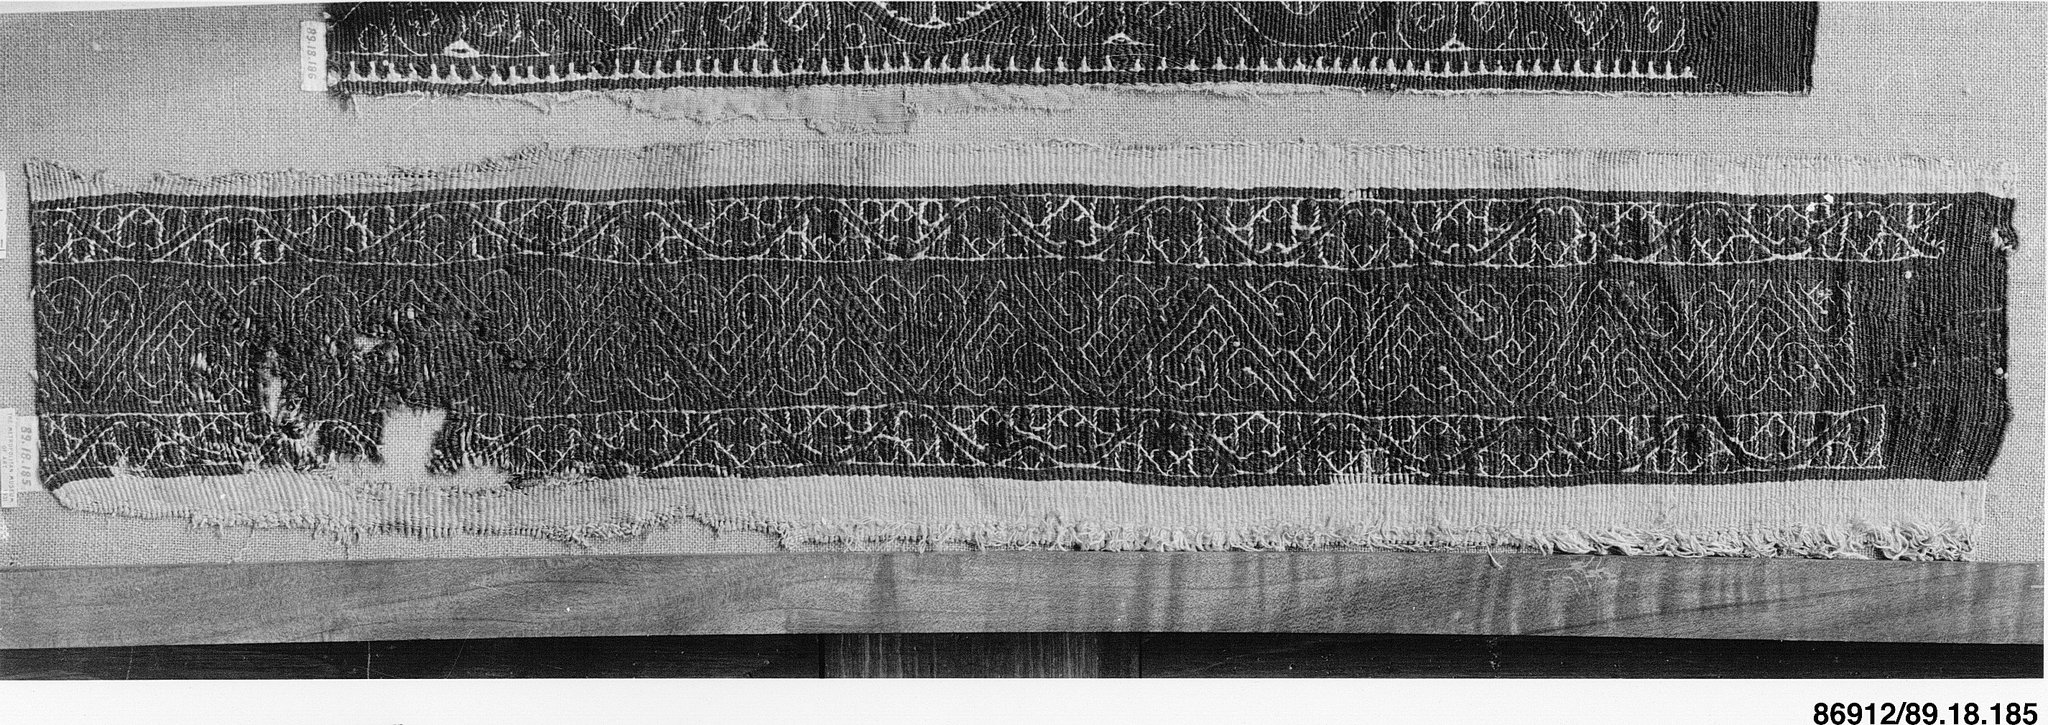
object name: textile fragment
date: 201-400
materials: linen, wool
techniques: weave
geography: egypt